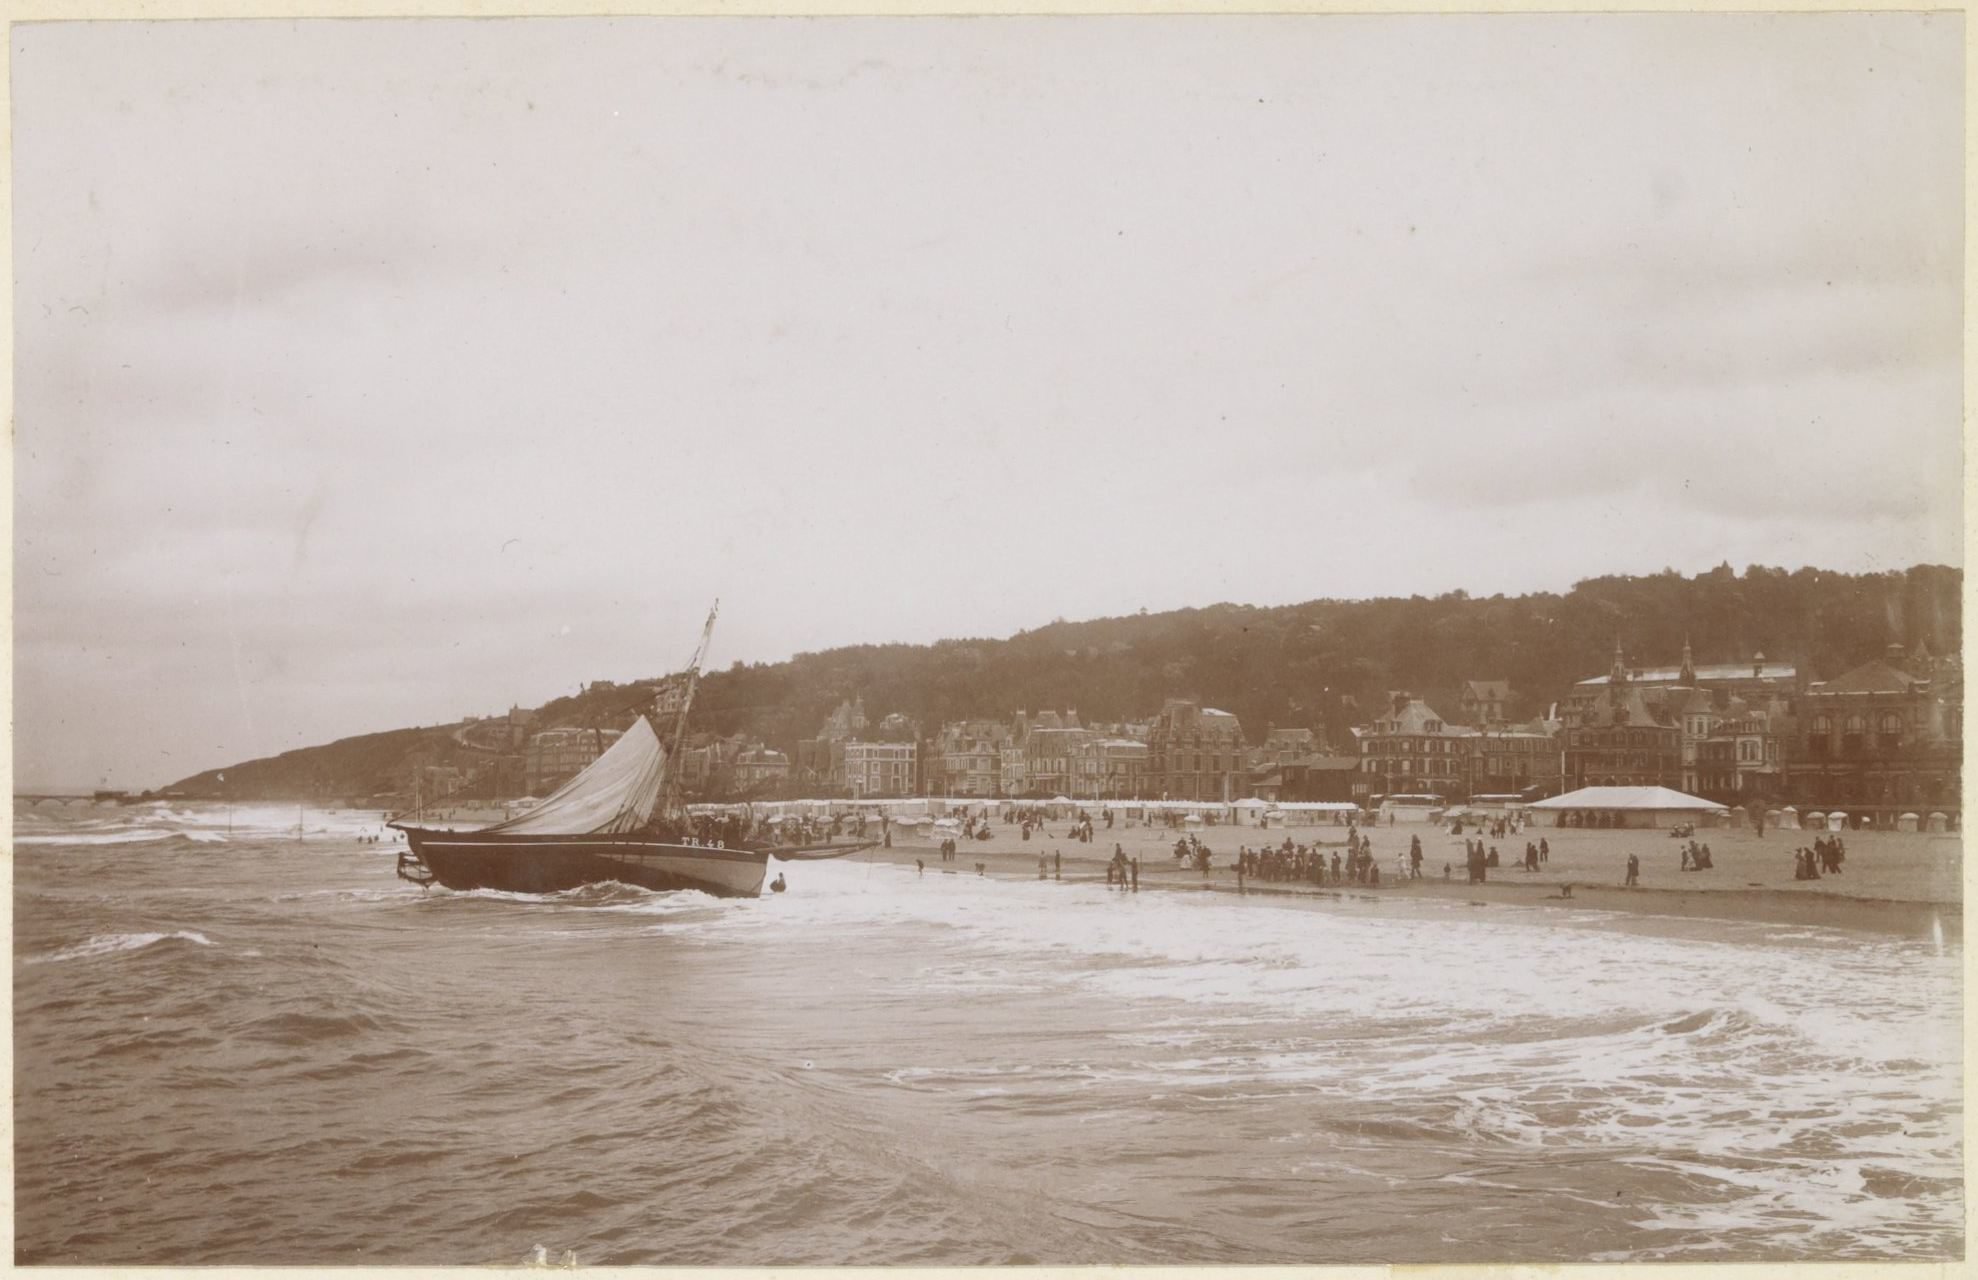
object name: photograph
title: Gezicht op (vermoedelijk) de Franse kust met zeilboot, huizen en mensen op het strand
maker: Anonymous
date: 1900-1910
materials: paper, photographic support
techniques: daylight paper print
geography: france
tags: sailing-ship, sailing-boat, beach, ships, boats on land, beached, france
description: Onderdeel van Fotoalbum van een Franse amateurfotograaf met opnames van een familie, distilleerderij Delizy & Doistau Fils, het leger en bezienswaardigheden in Frankrijk.